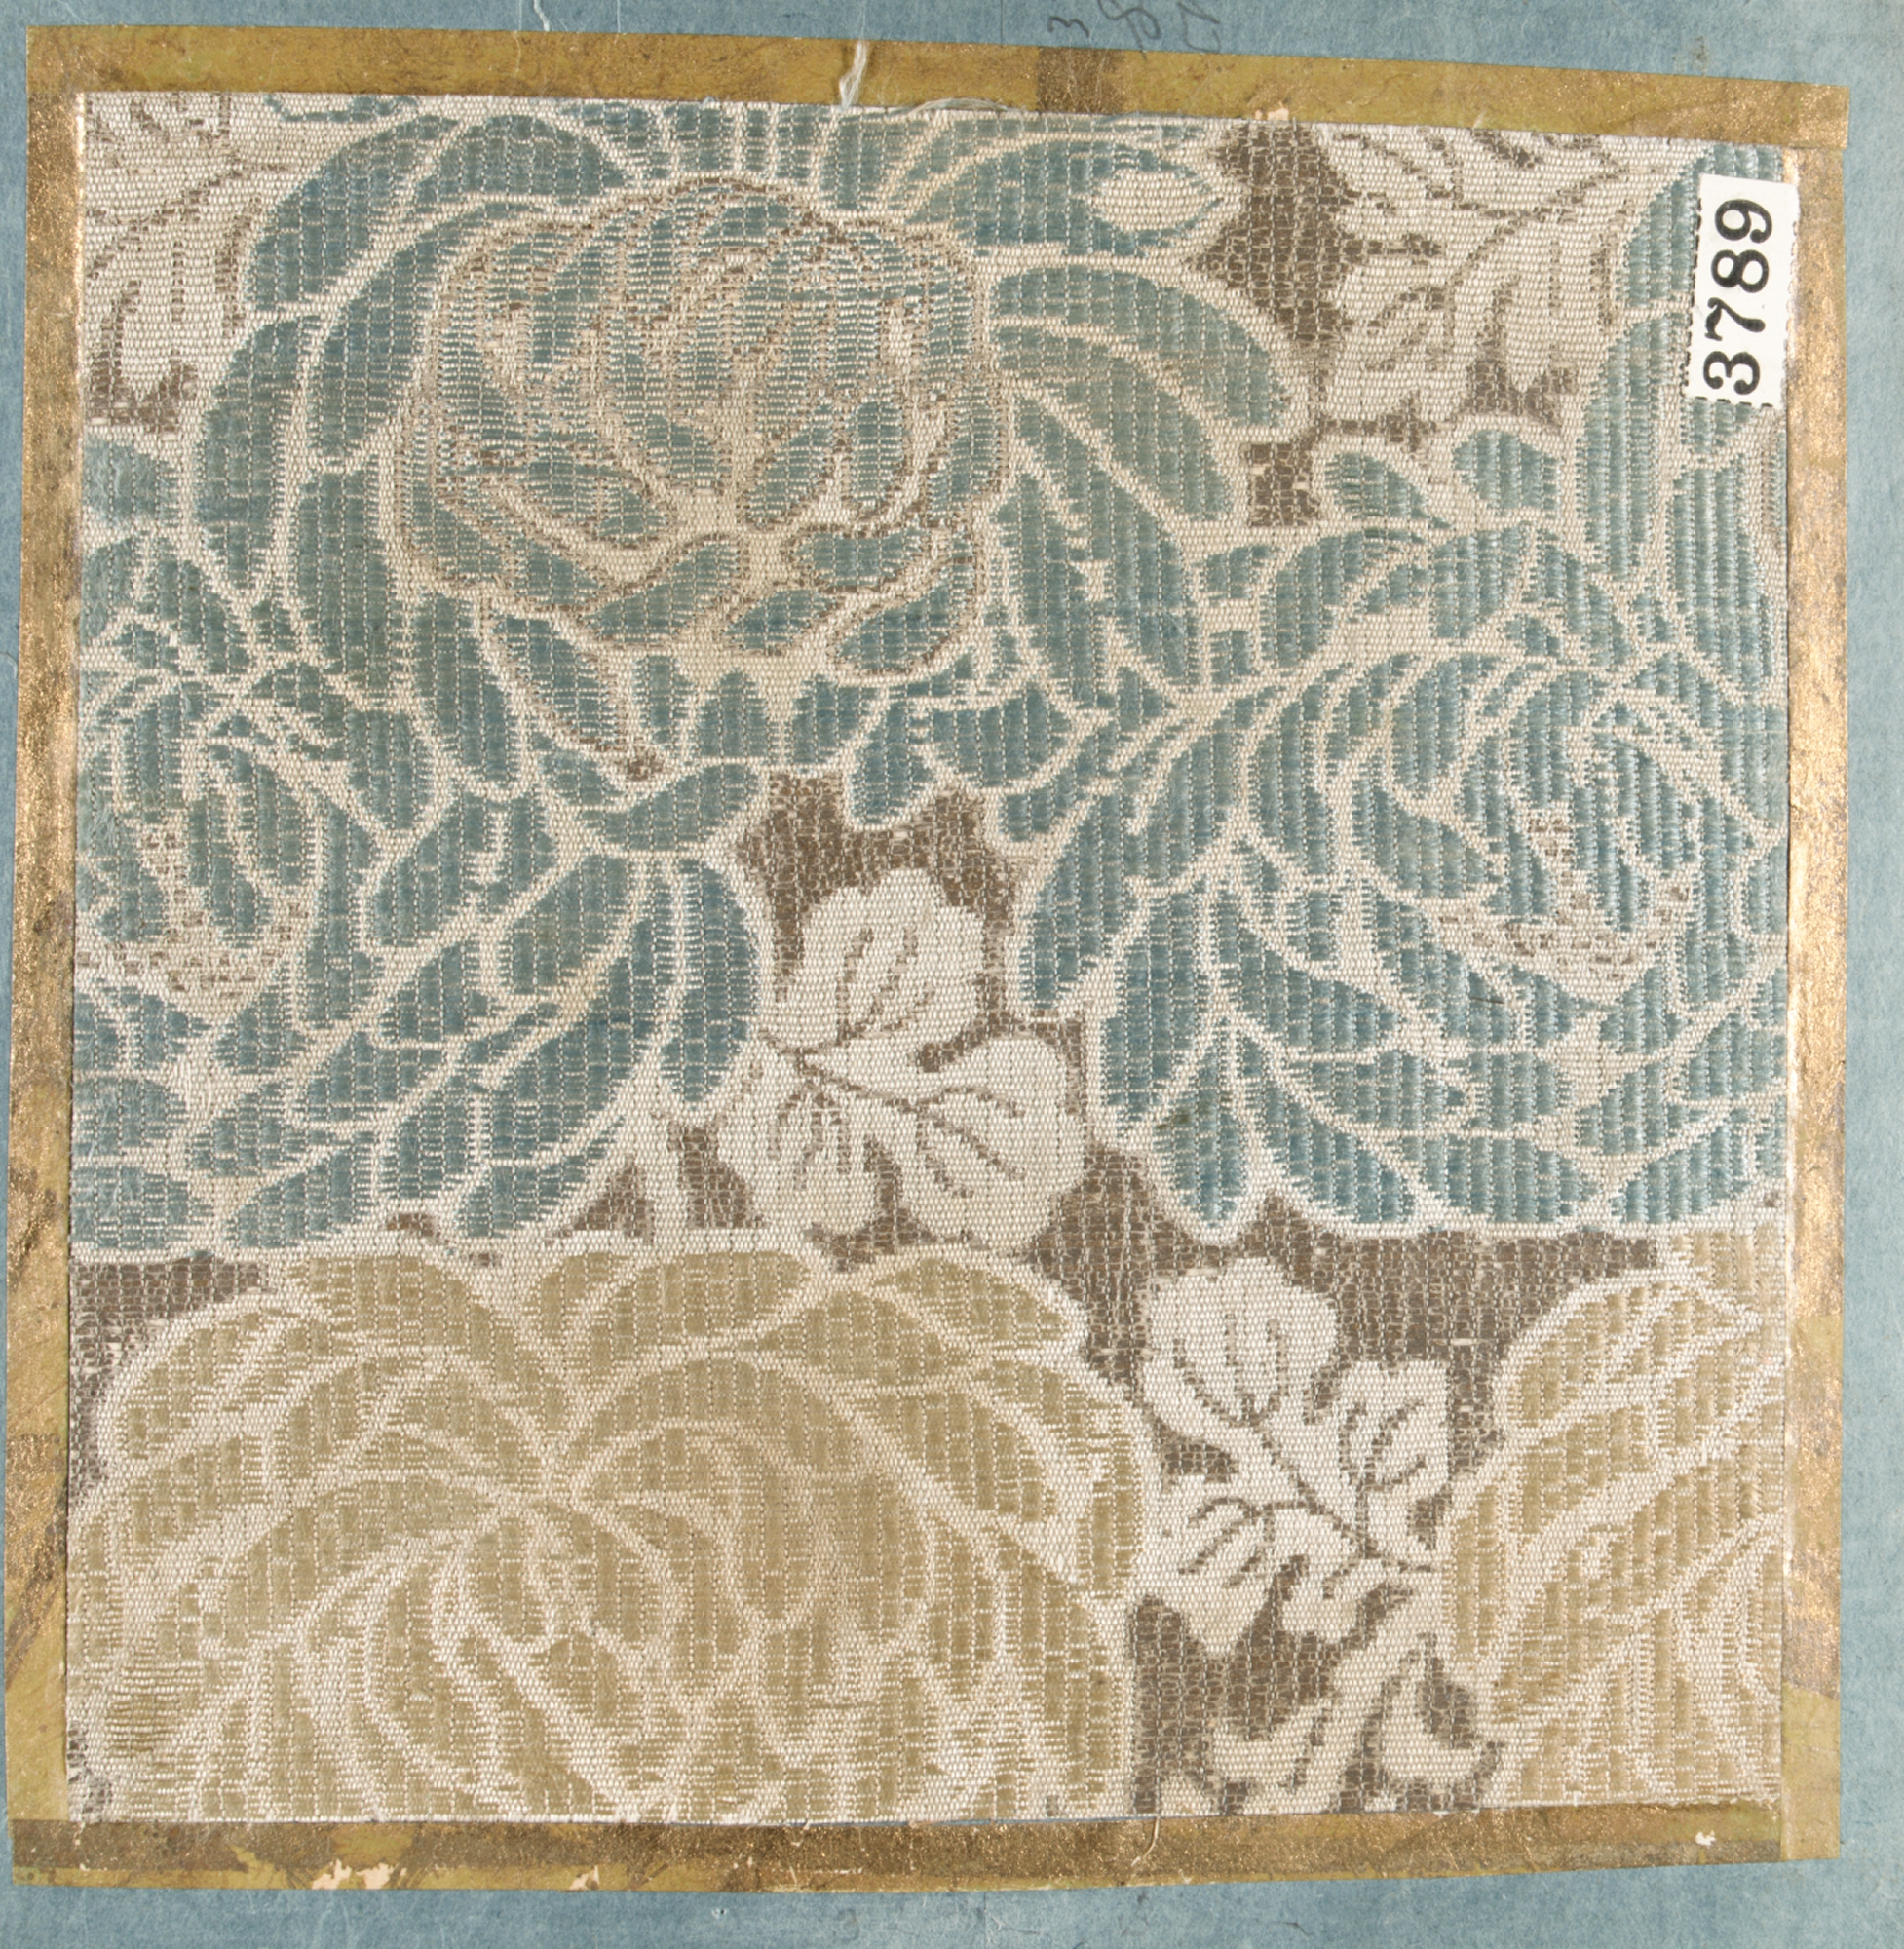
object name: sample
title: Textile Sample from Sample Book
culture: japanese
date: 1801-1900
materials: silk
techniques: tapestry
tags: flowers